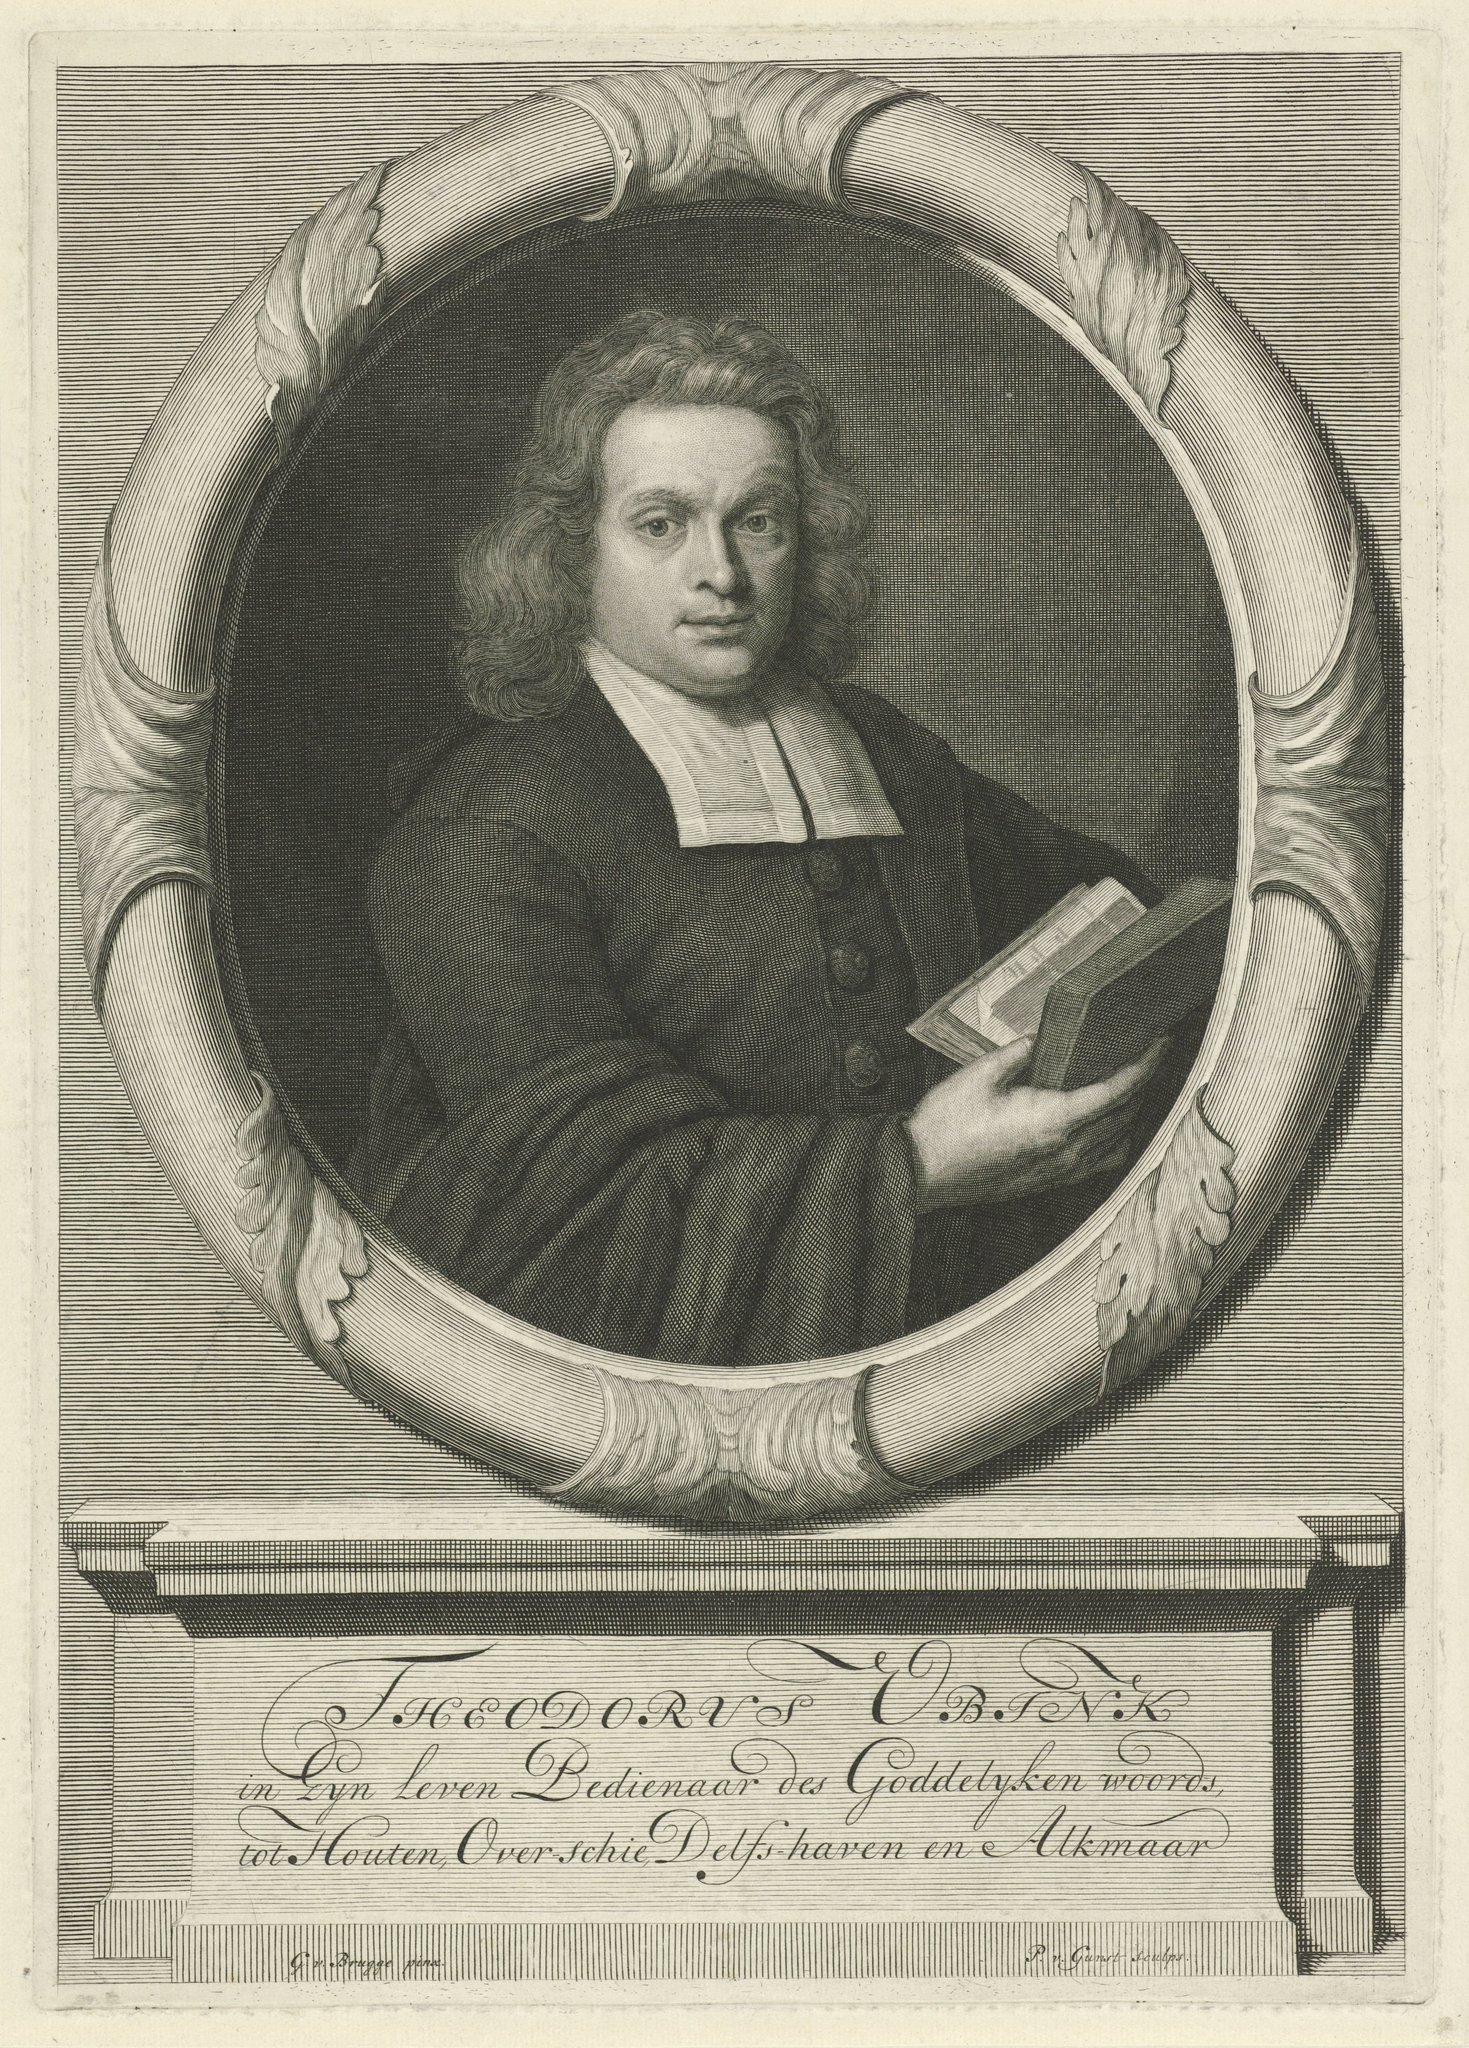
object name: print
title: Portret van Theodoor Ubink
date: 1709-1731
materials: paper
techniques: engraving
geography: amsterdam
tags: alkmaar, predikant, theodoor ubink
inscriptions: collector's mark: Lugt 240, collector's mark: Lugt 2228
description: Theodoor Ubink, predikant in Houten, Delshaven en Alkmaar. In zijn handen een bijbel.